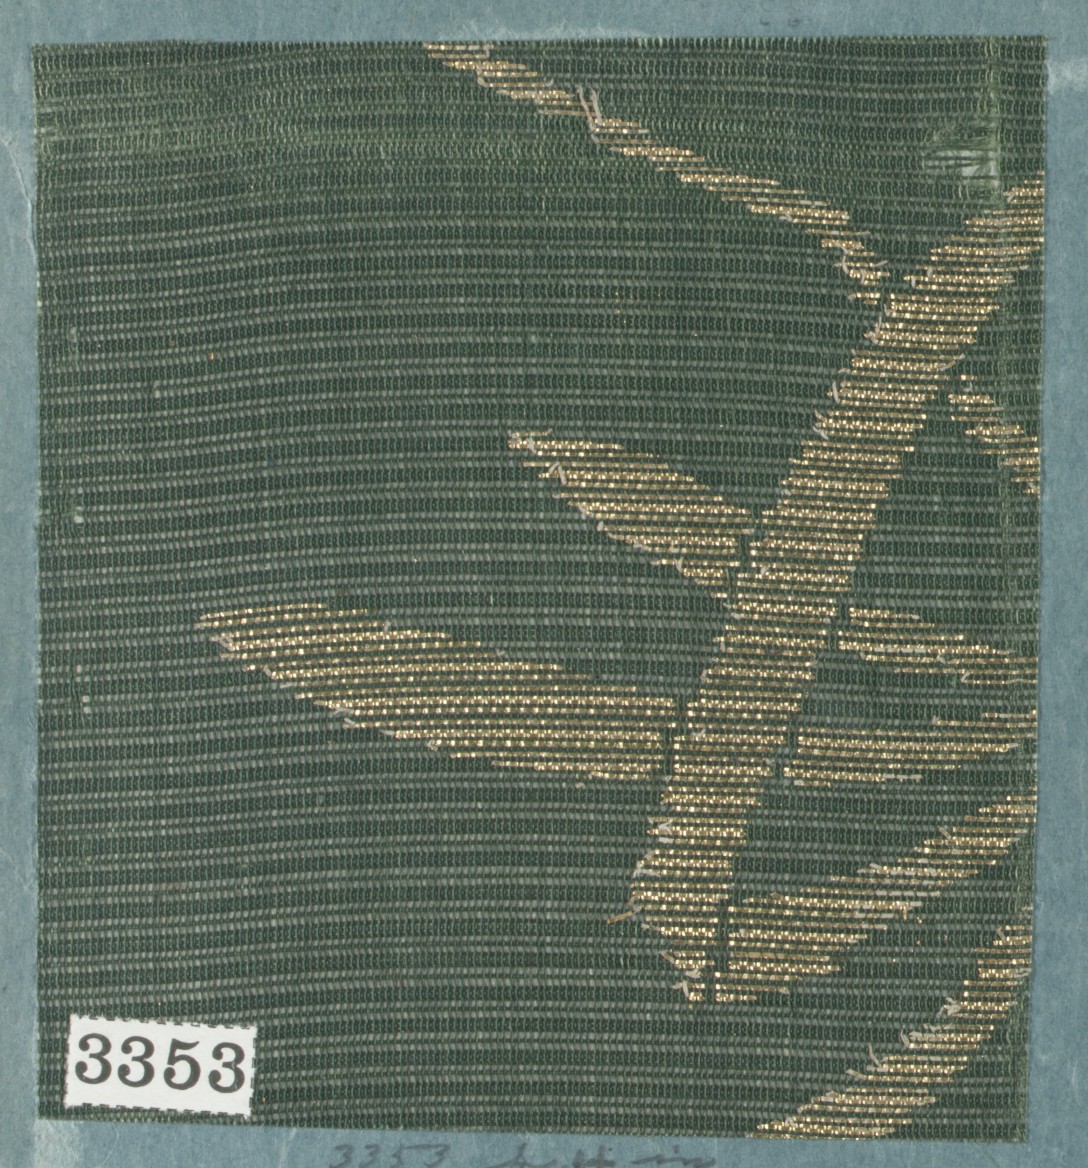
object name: textile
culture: japanese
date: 1801-1900